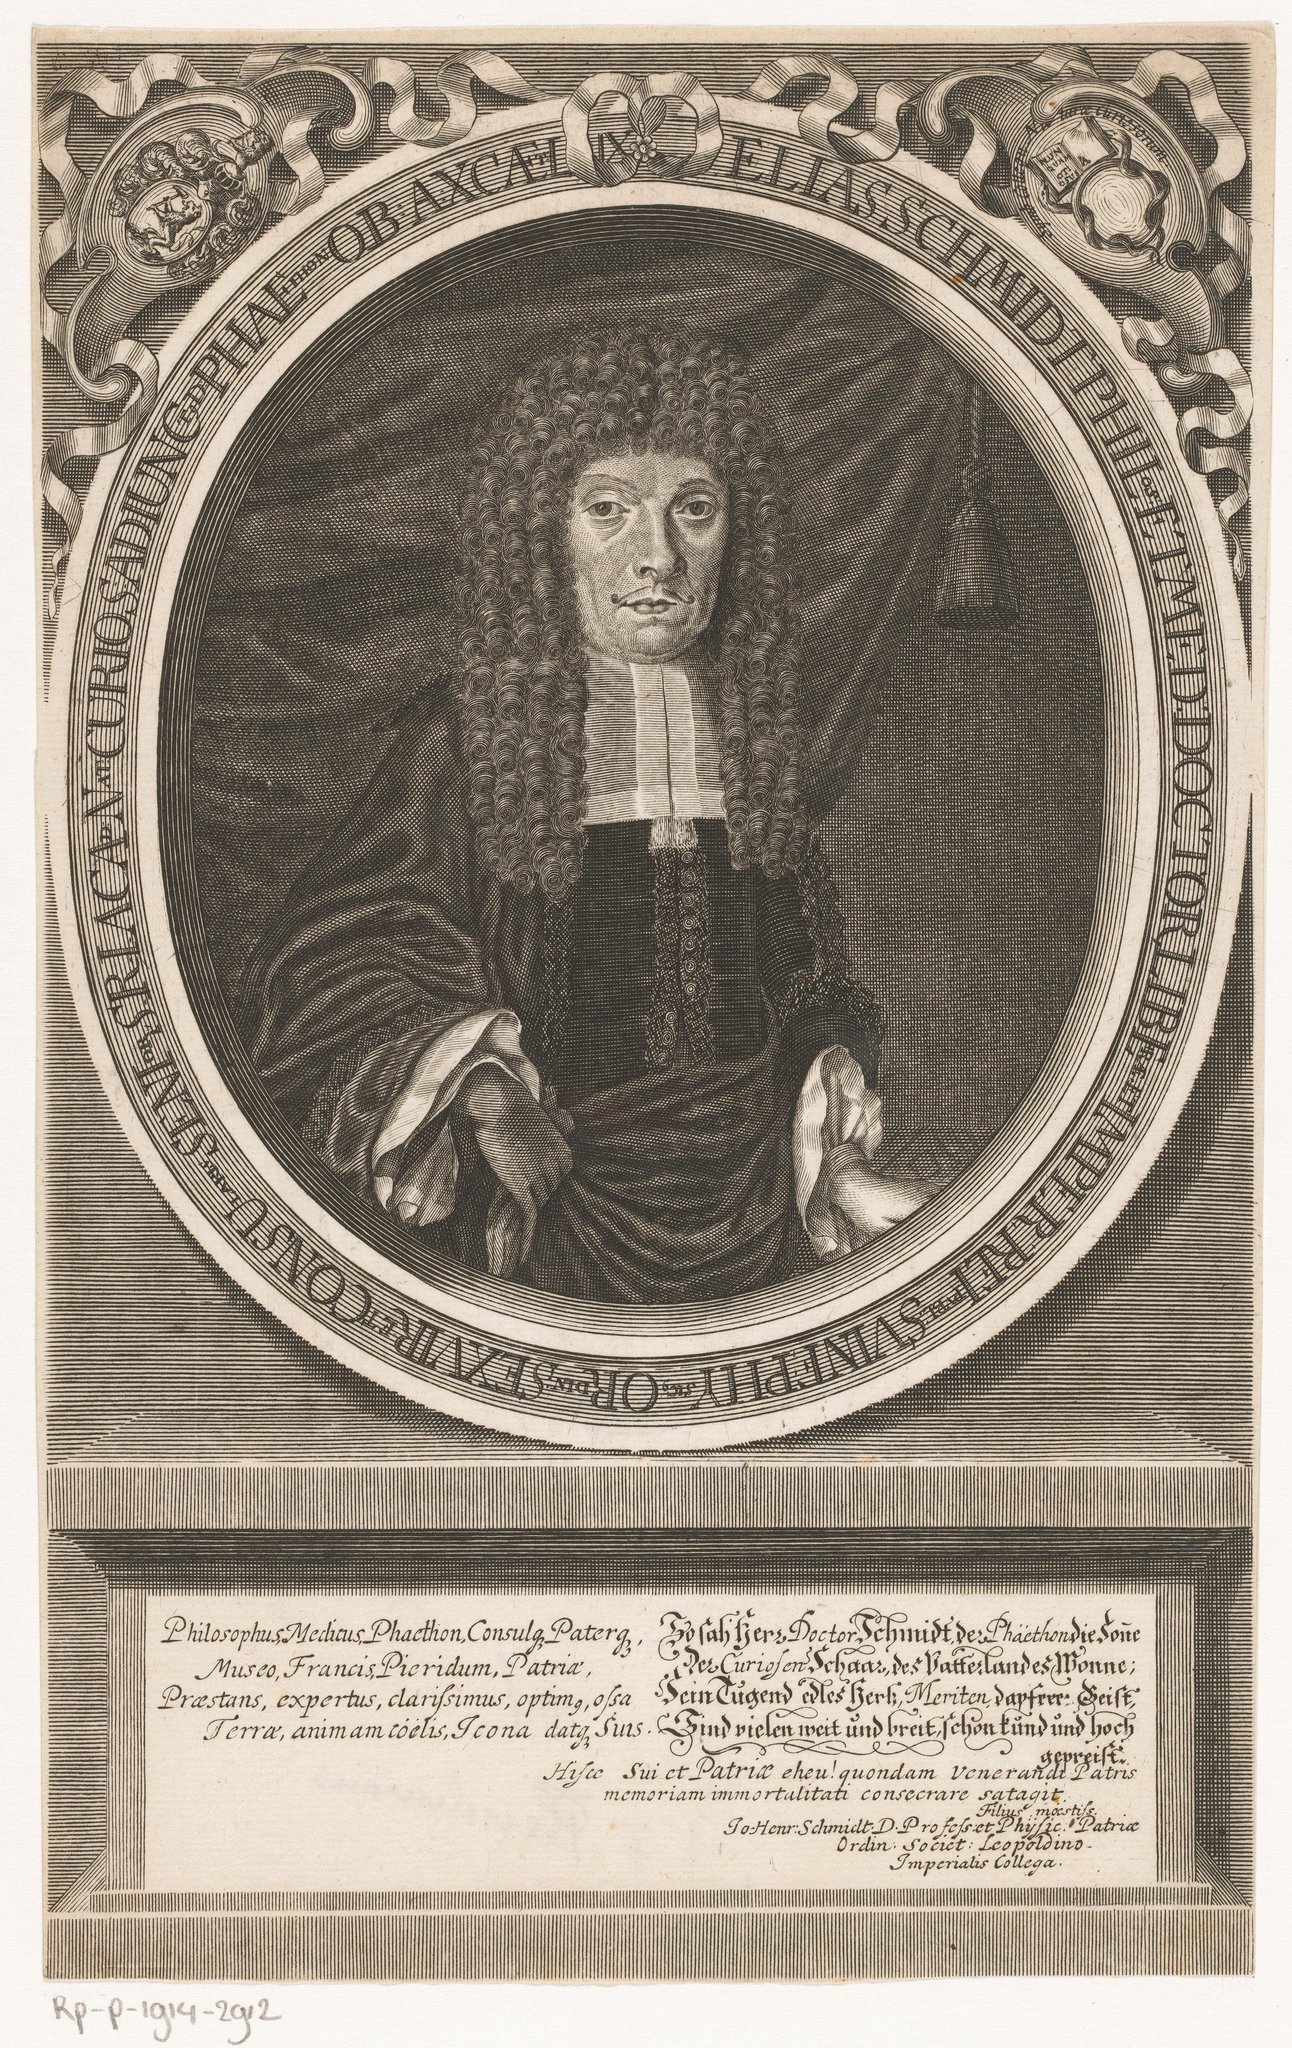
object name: print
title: Portret van Elias Schmidt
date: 1704-1732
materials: paper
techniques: engraving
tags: (feigned) picture curtain, historical persons, ribbon, scroll, banderole ~ ornament, abstract ideas and concepts (+ emblematical representation of concept), armorial bearing, heraldry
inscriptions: collector's mark: Lugt 2228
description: Met lofdicht in het Latijn en het Duits.